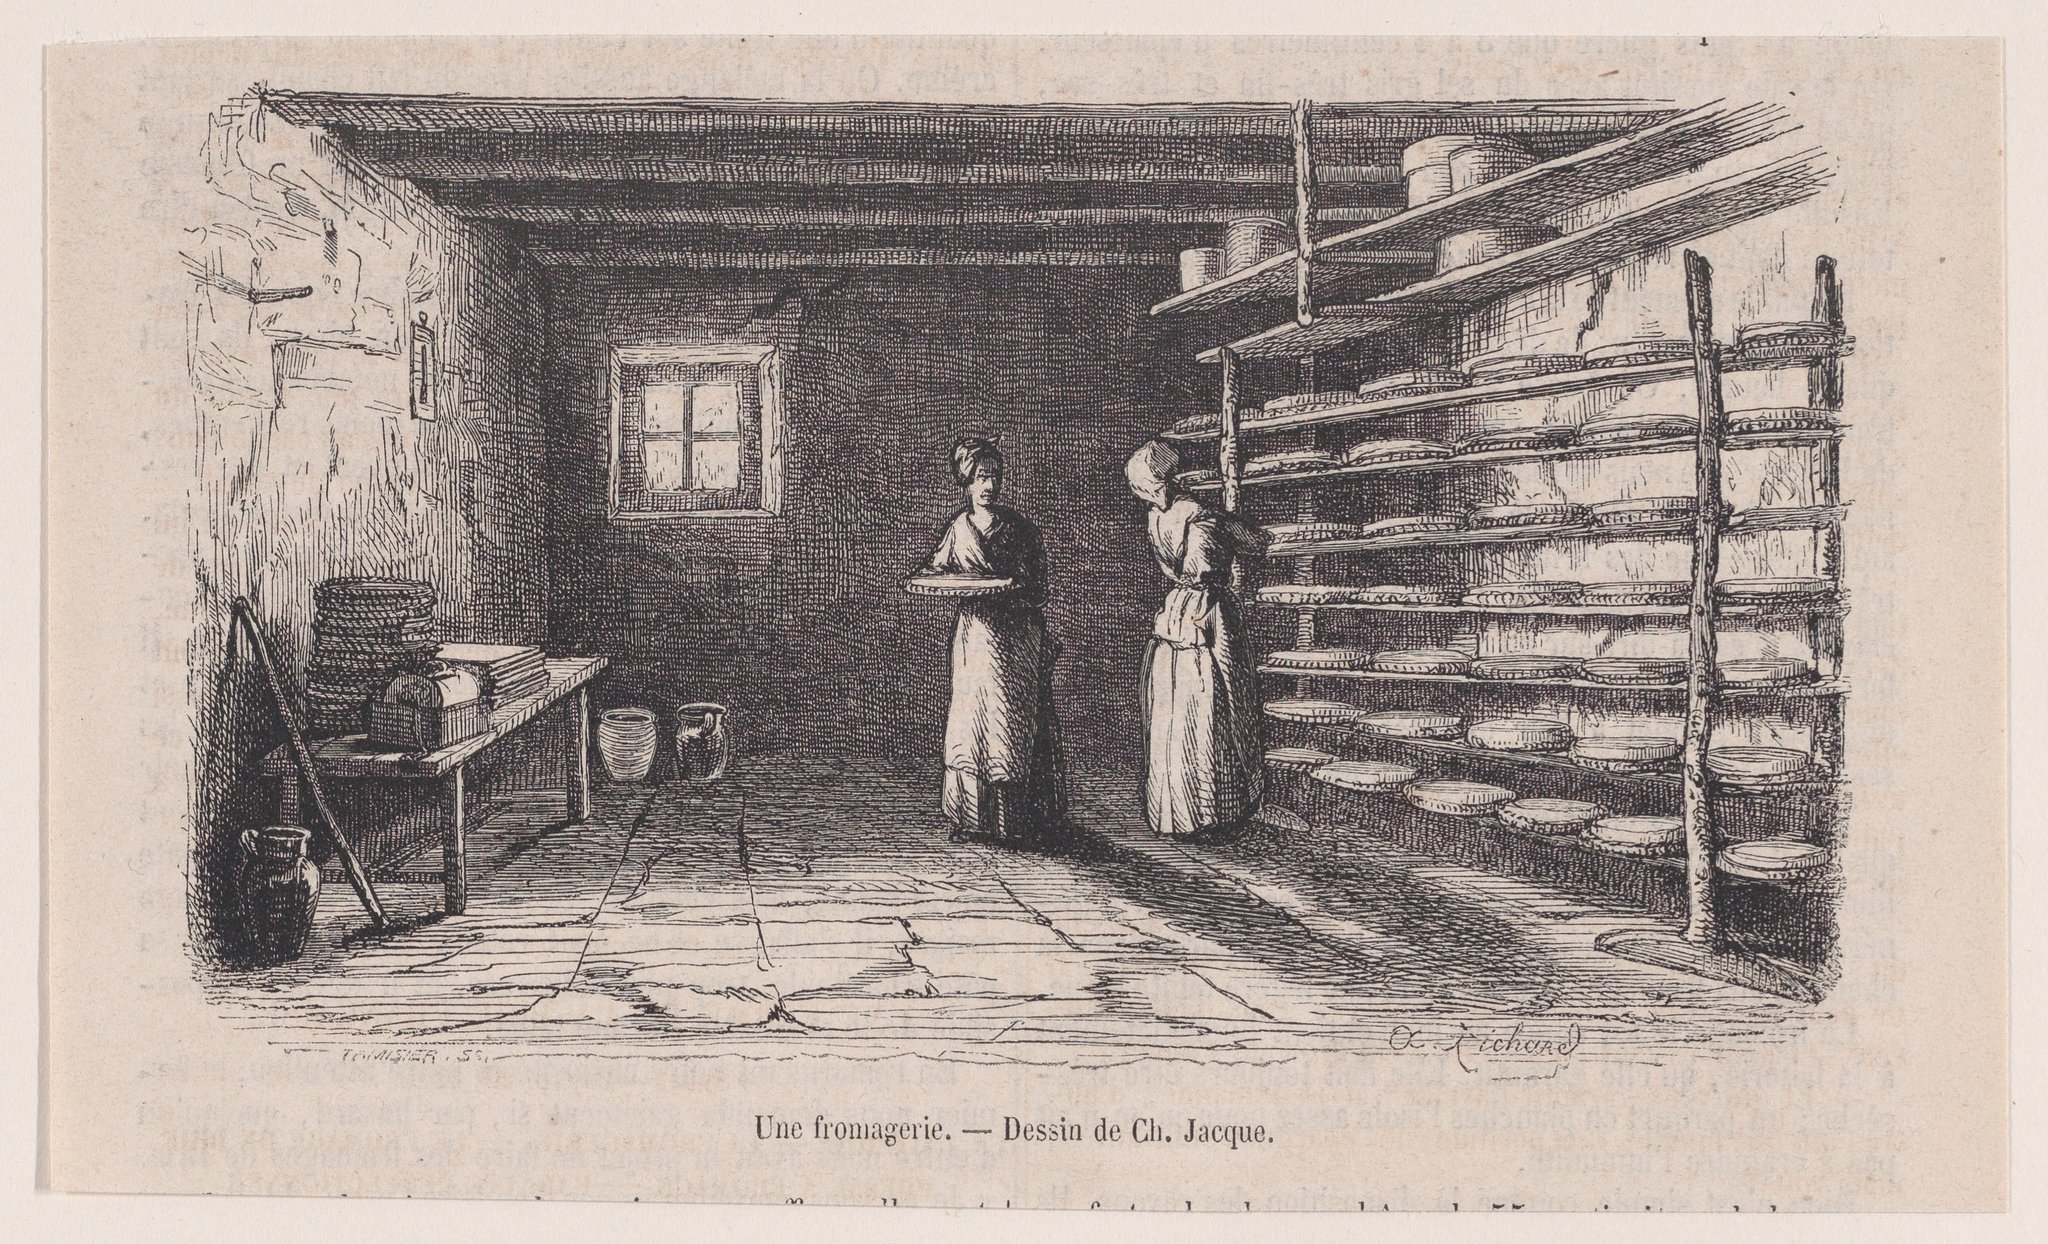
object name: print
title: A Dairy, from "Le Magasin Pittoresque"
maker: charles émile jacque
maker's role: artist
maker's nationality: french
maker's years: 1813-1894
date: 1852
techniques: engraving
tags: interiors,cheese,women